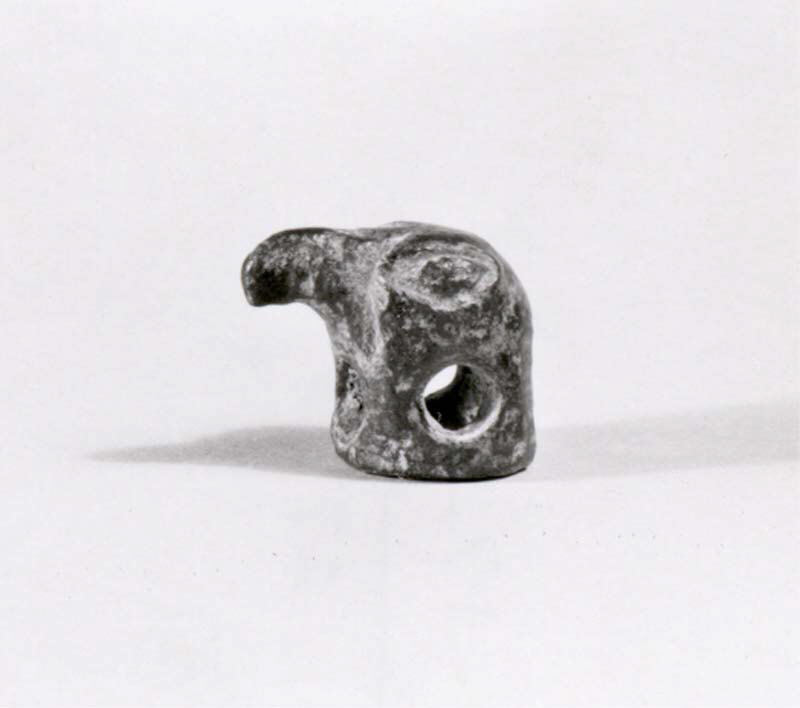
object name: harness or bridle fitting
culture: scythian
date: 700-501 BCE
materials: bronze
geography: western asia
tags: birds